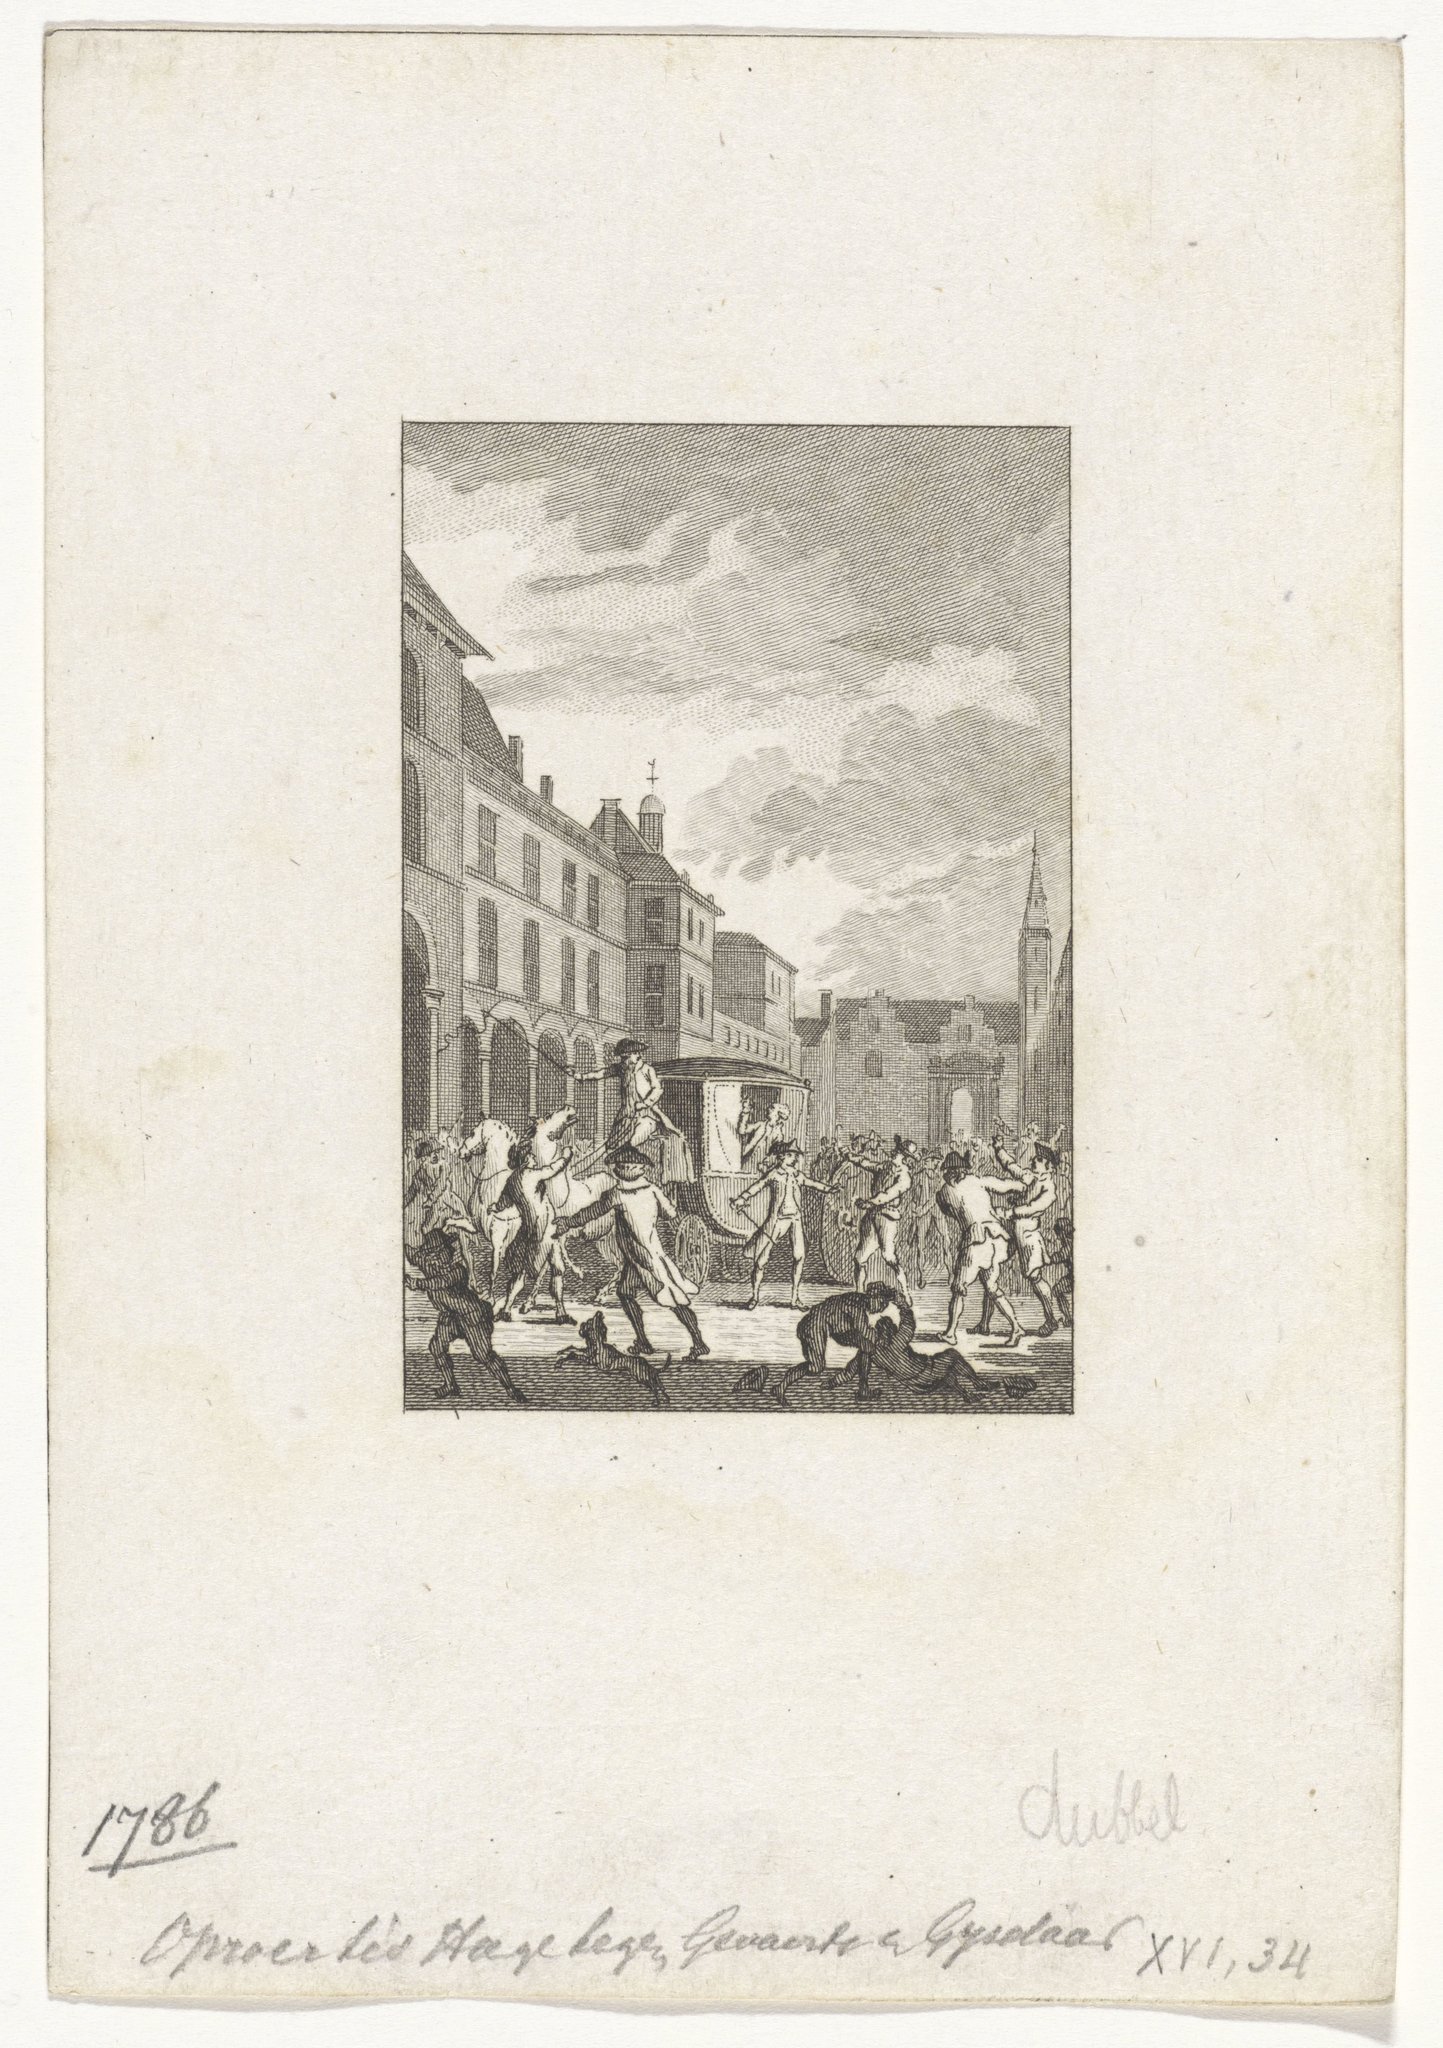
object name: print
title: Aanslag op het rijtuig van de gedeputeerden van Dordrecht, 1786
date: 1783-1795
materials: paper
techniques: etching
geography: amsterdam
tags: revolutionary action (violent)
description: Aanslag door de Haagse pruikenmaker F. Mourand op het rijtuig van de gedeputeerden van Dordrecht, de heren Gevaerts en De Gijzelaar, als zij door de Stadhouderspoort het Binnenhof op willen rijden, 17 maart 1786.